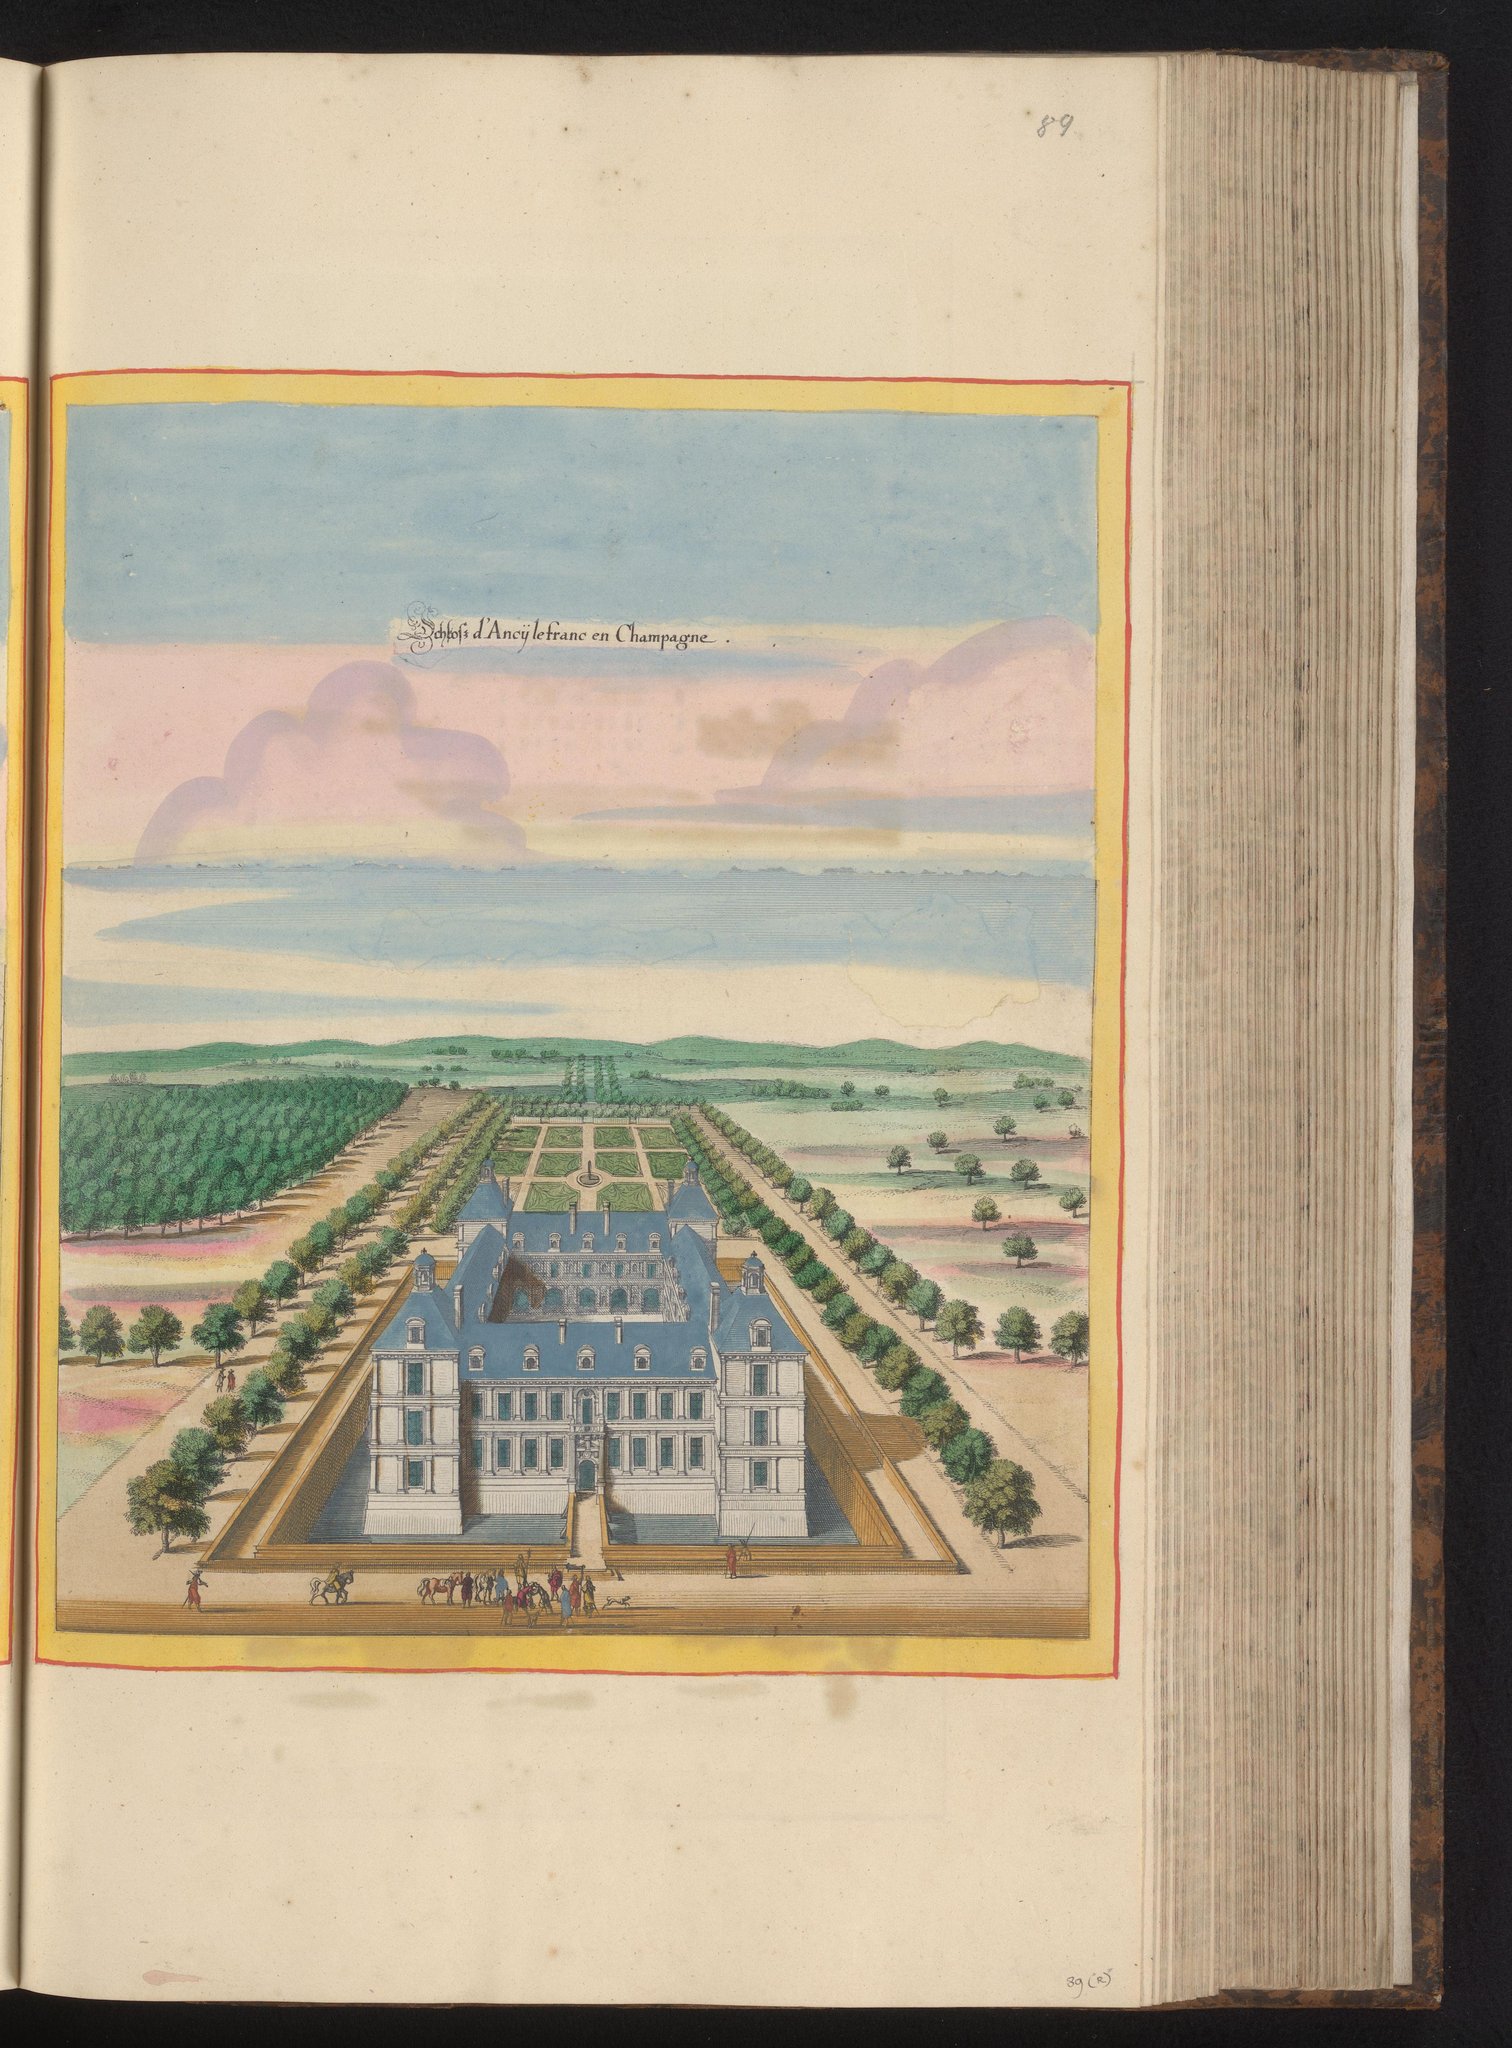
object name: print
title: Gezicht op het Château d'Annecy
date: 1656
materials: paper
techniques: engraving, etching, hand coloring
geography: the hague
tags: castle, landscape with tower or castle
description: Prent uit: Zeiller, Martin. Topographia Galliae. 13 dln. Frankfurt: Caspar Merian, 1656, dl. 3, na p. 18.